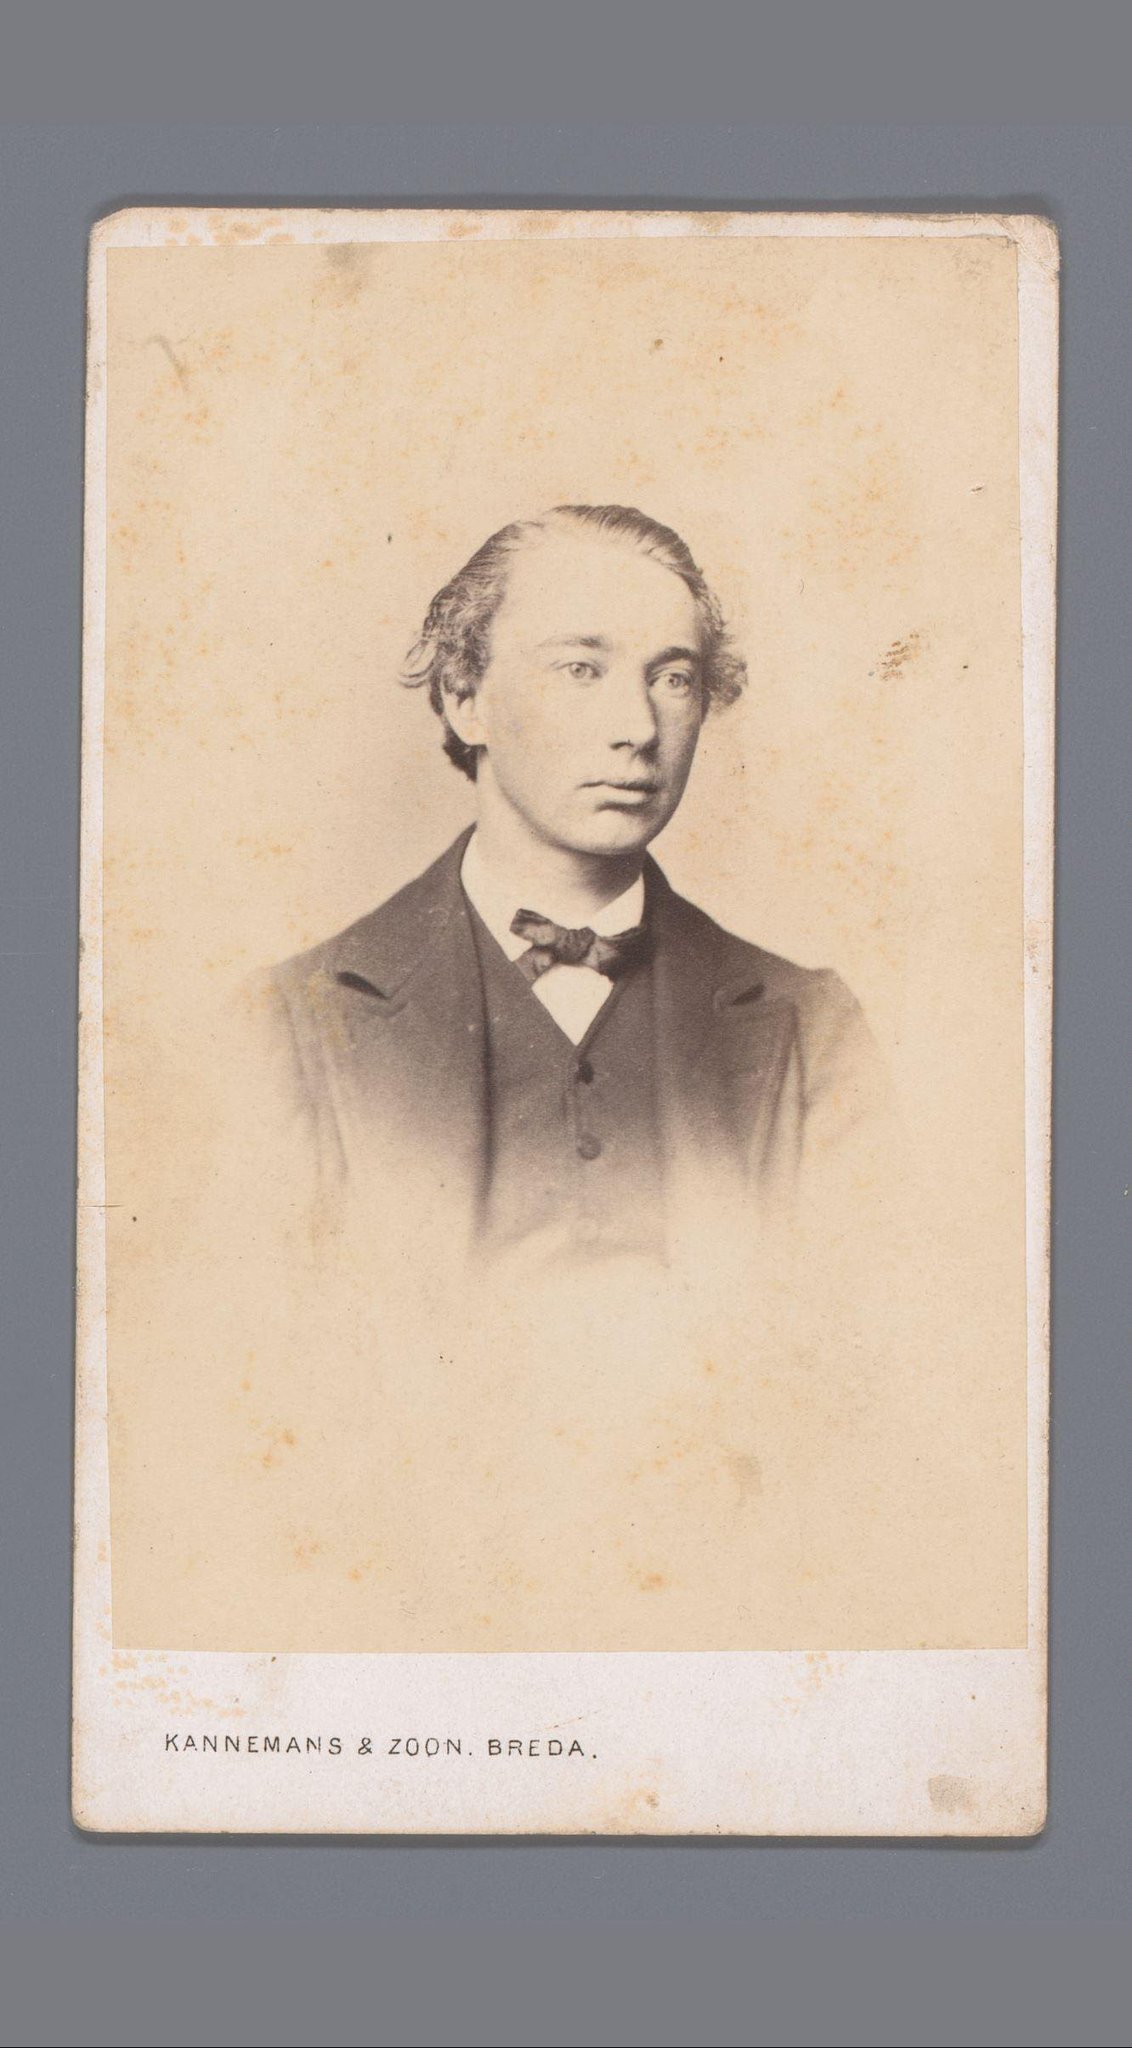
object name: photograph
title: Portret van een onbekende man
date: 1867-1879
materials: cardboard, paper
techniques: albumen print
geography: breda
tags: adult man, historical persons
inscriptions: inscription: ‘KANNEMANS EN ZOON/ Artiste Photographen/ VAN/ Z.M. DEN KONING EN H.M. DE KONINGIN/ BREDA/ Groote Markt/ D. 15./ tegen over het Stadhuis’